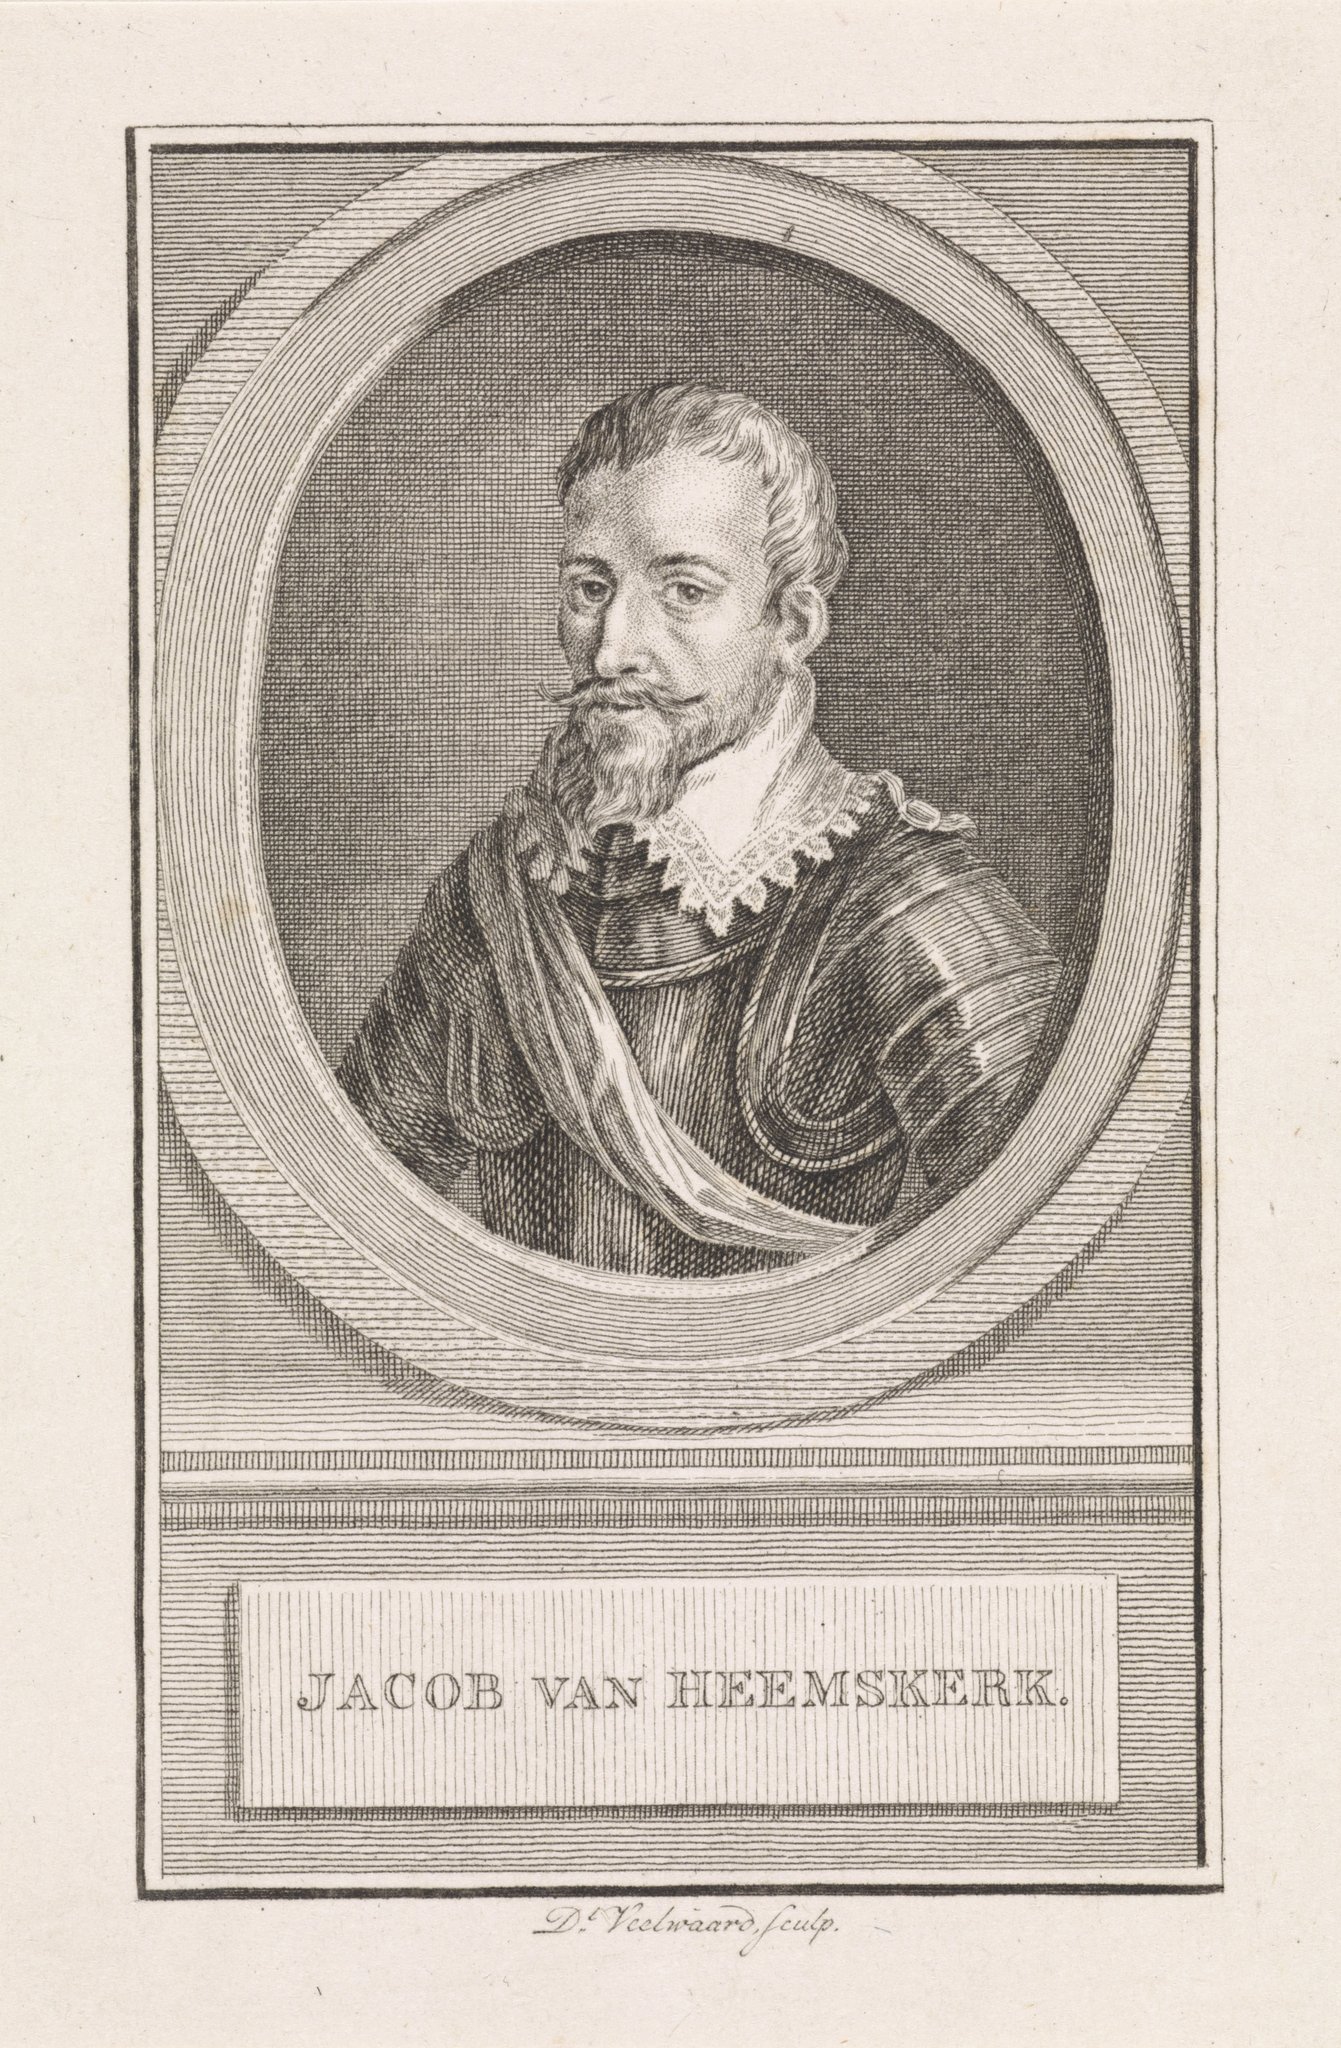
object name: print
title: Portret van de admiraal Jacob van Heemskerck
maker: daniël veelwaard (i)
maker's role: print maker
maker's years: 1766-1851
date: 1776-1851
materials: paper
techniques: engraving, etching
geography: amsterdam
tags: amsterdam, jacob van heemskerck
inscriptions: collector's mark: Lugt 2228